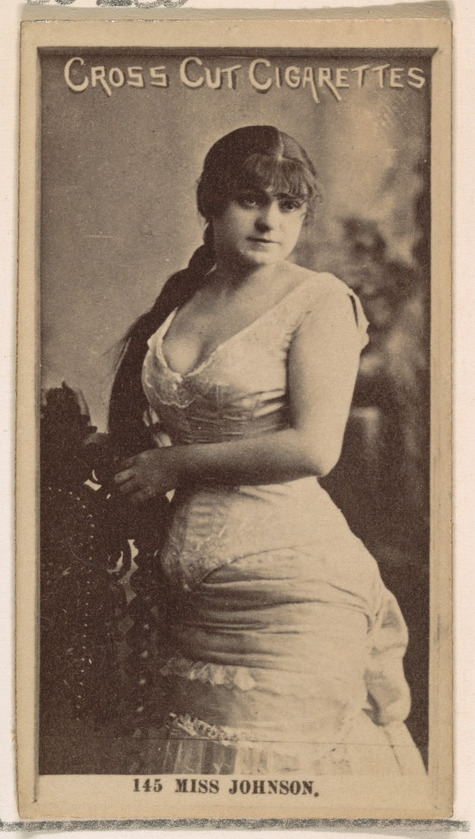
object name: print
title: Card Number 145, Miss Johnson, from the Actors and Actresses series (N145-2) issued by Duke Sons & Co. to promote Cross Cut Cigarettes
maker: w. duke, sons & co.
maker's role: publisher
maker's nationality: american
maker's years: 1870-1920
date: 1880-1889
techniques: albumen silver print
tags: portraits,women,actresses